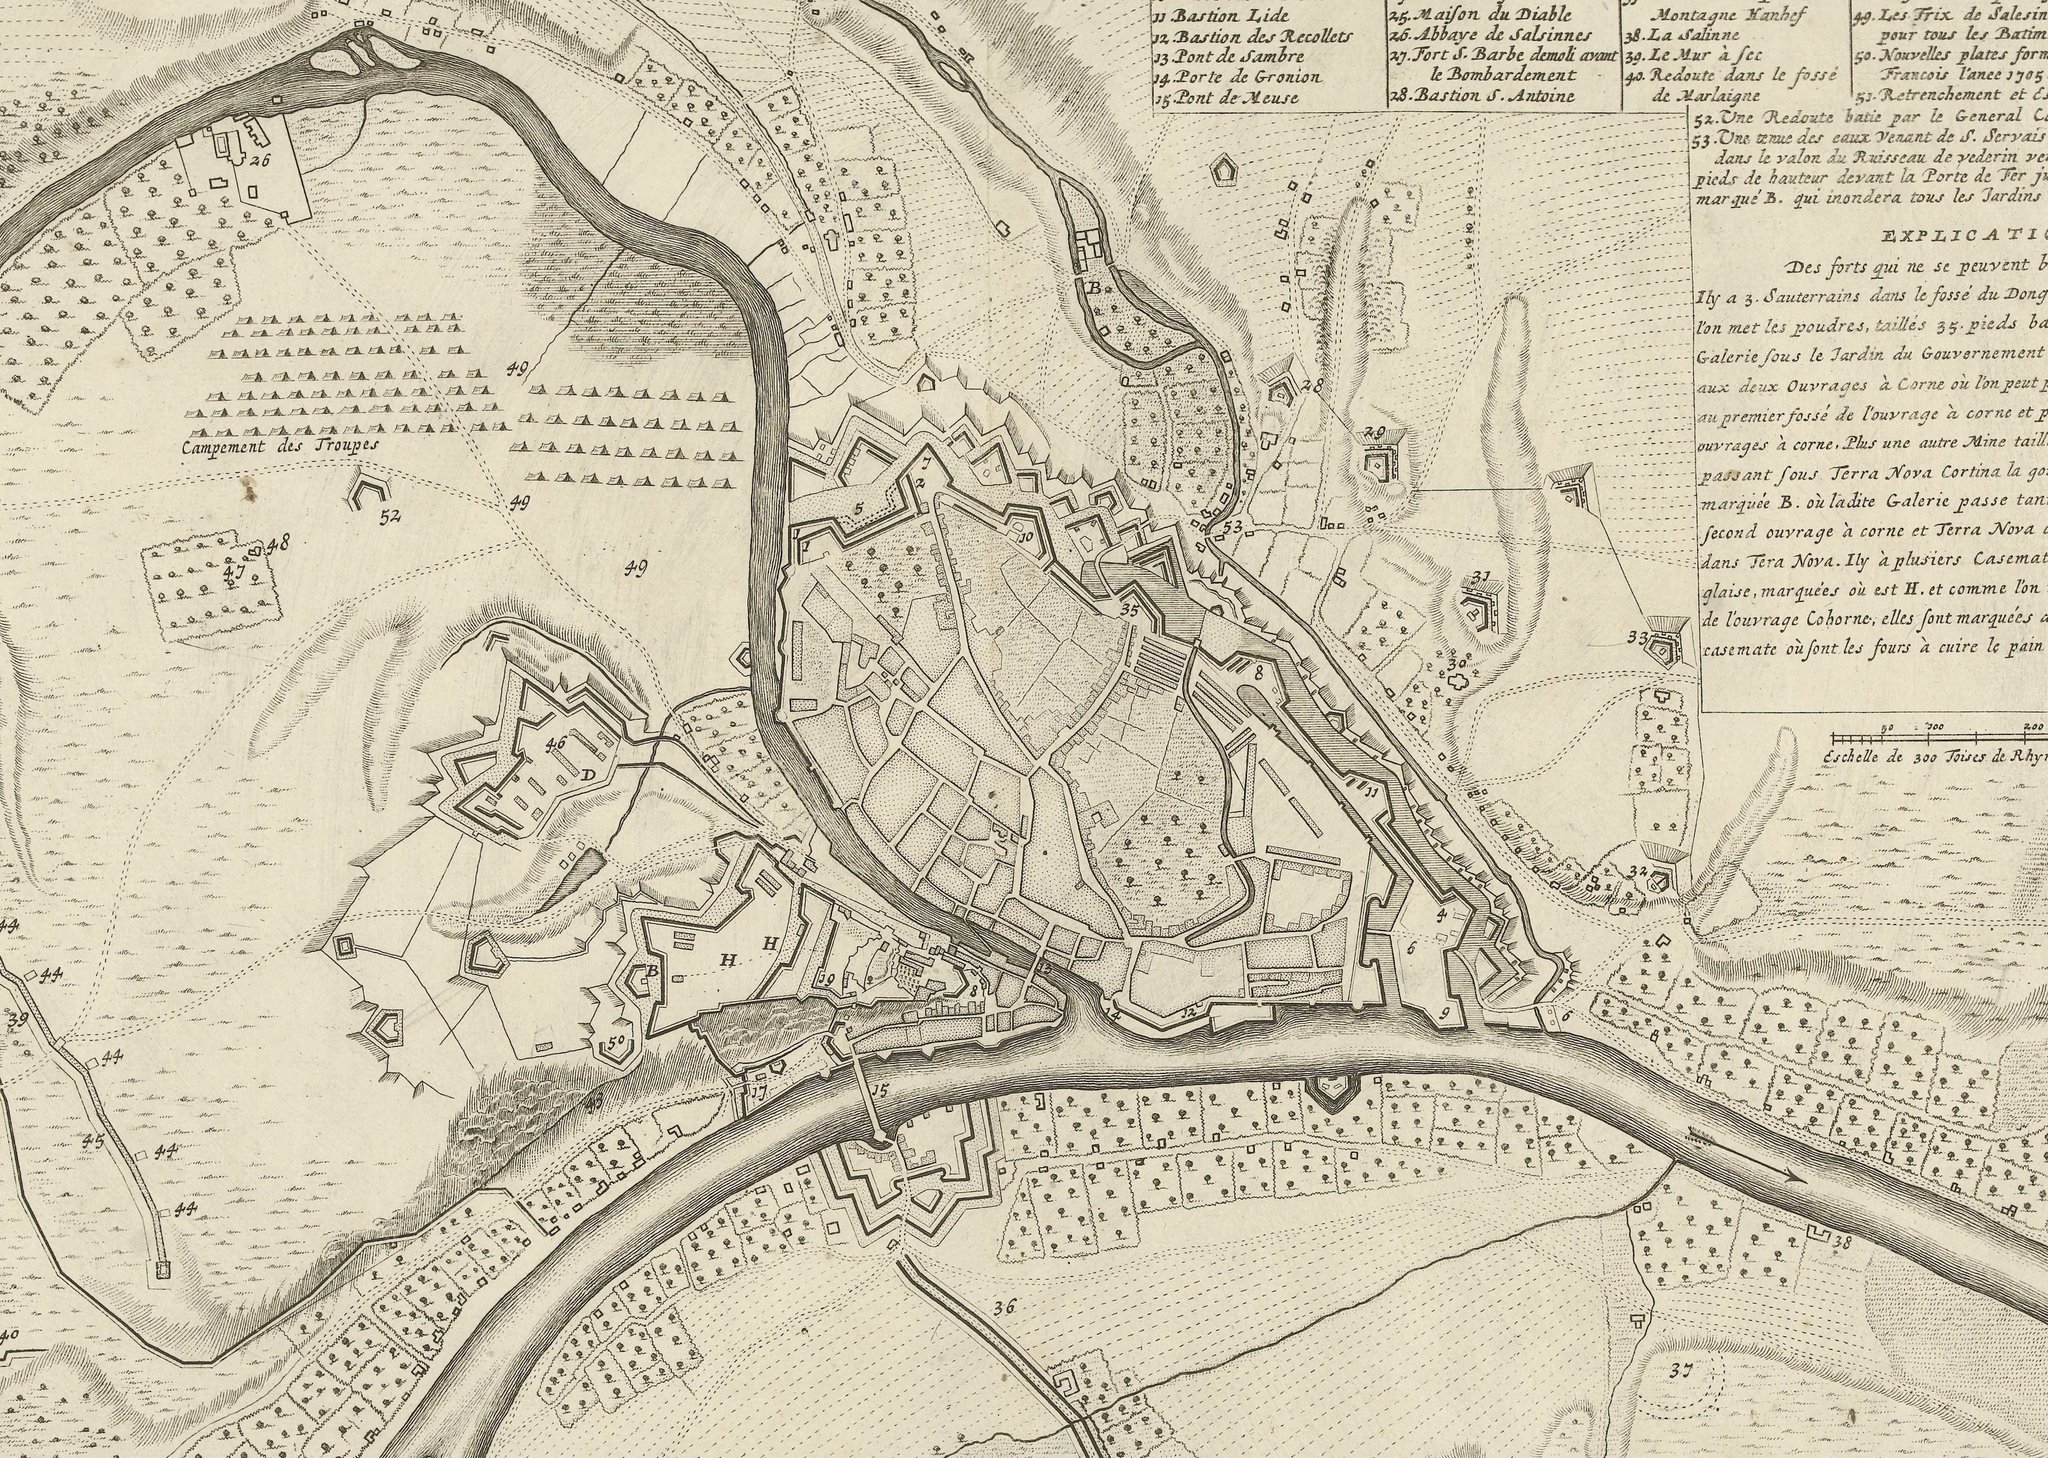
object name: area plan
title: Plan de la ville et château de Namur avec les dernieres fortifications faites jusqu à l'an 1709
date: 1709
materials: paper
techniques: etching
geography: brussels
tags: maps of cities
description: Plattegrond van Namen met de versterkingen tot aan het jaar 1709. Rechtsboven de legenda 1-53 en een verklaring. Onderdeel van een gebundelde verzameling van plannen van veldslagen en steden vermaard in de Spaanse Successieoorlog.